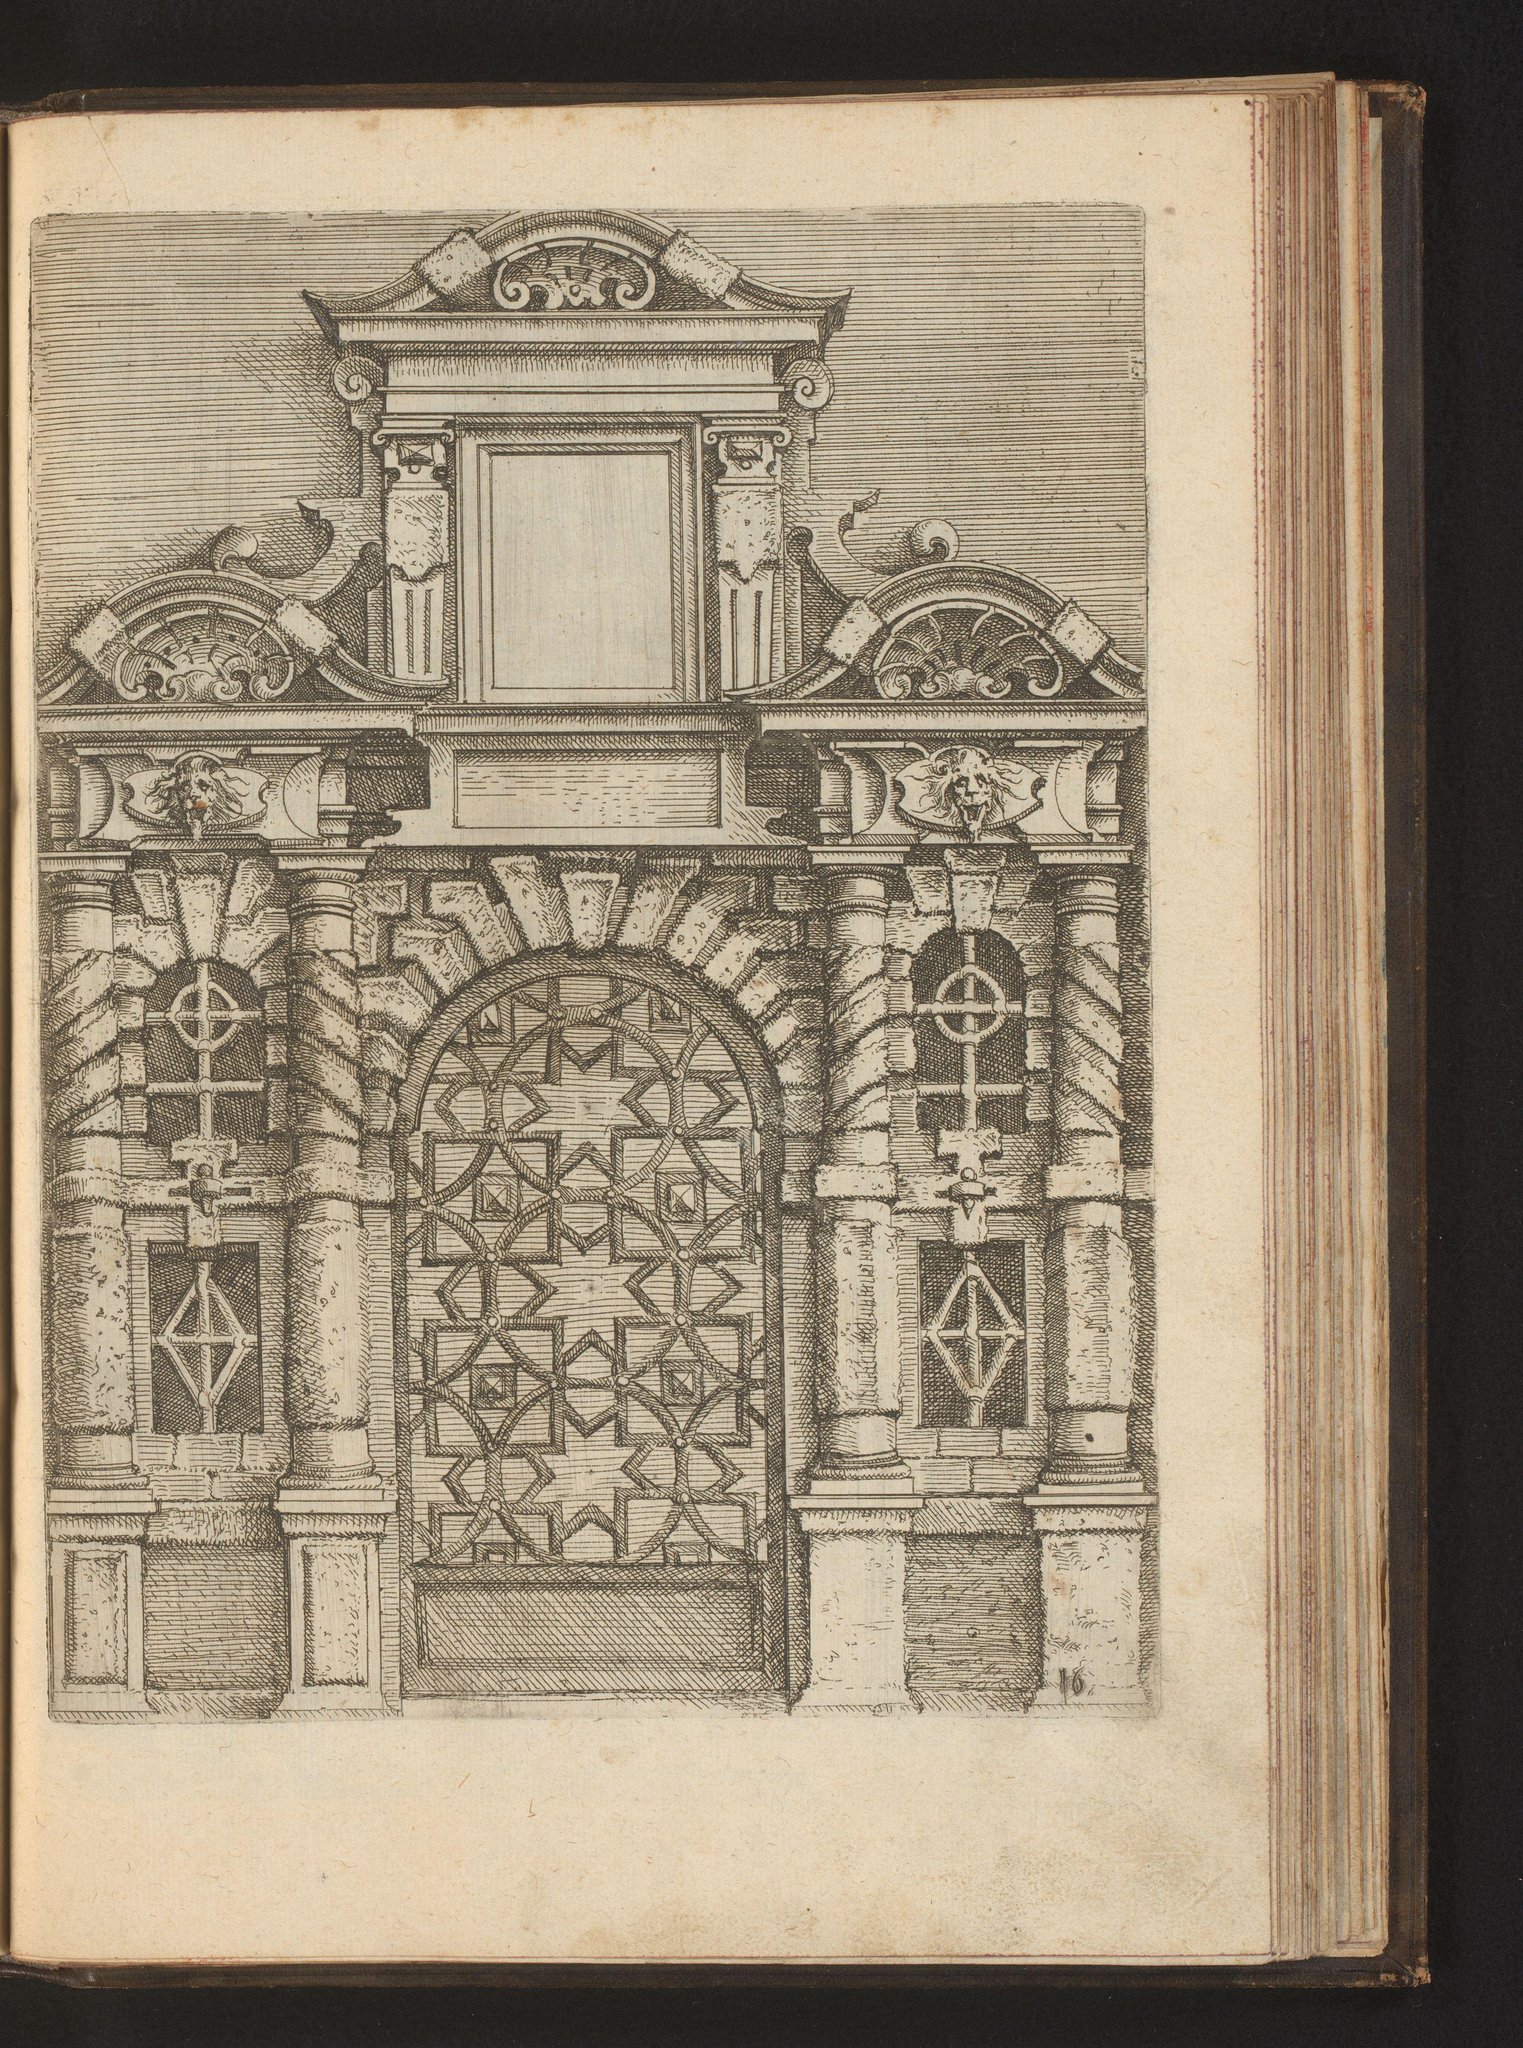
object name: book illustration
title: Portaal afgesloten met ijzeren hek en motief van sterren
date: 1593-1595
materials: paper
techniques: etching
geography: straatsburg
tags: parts of church exterior and annexes: portal, doric order ~ architecture, scallop, shell ~ ornament, ornament derived from architectural details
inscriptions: collector's mark: Lugt 2228, collector's mark: Lugt 2760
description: Prent gebruikt in: Dietterlin, Wendel (I). Wendel Dietterlin, Architectura de Polstium seu Portalium ornatu uario Liber II. Straatsburg: Bernhard Jobin, 1594.